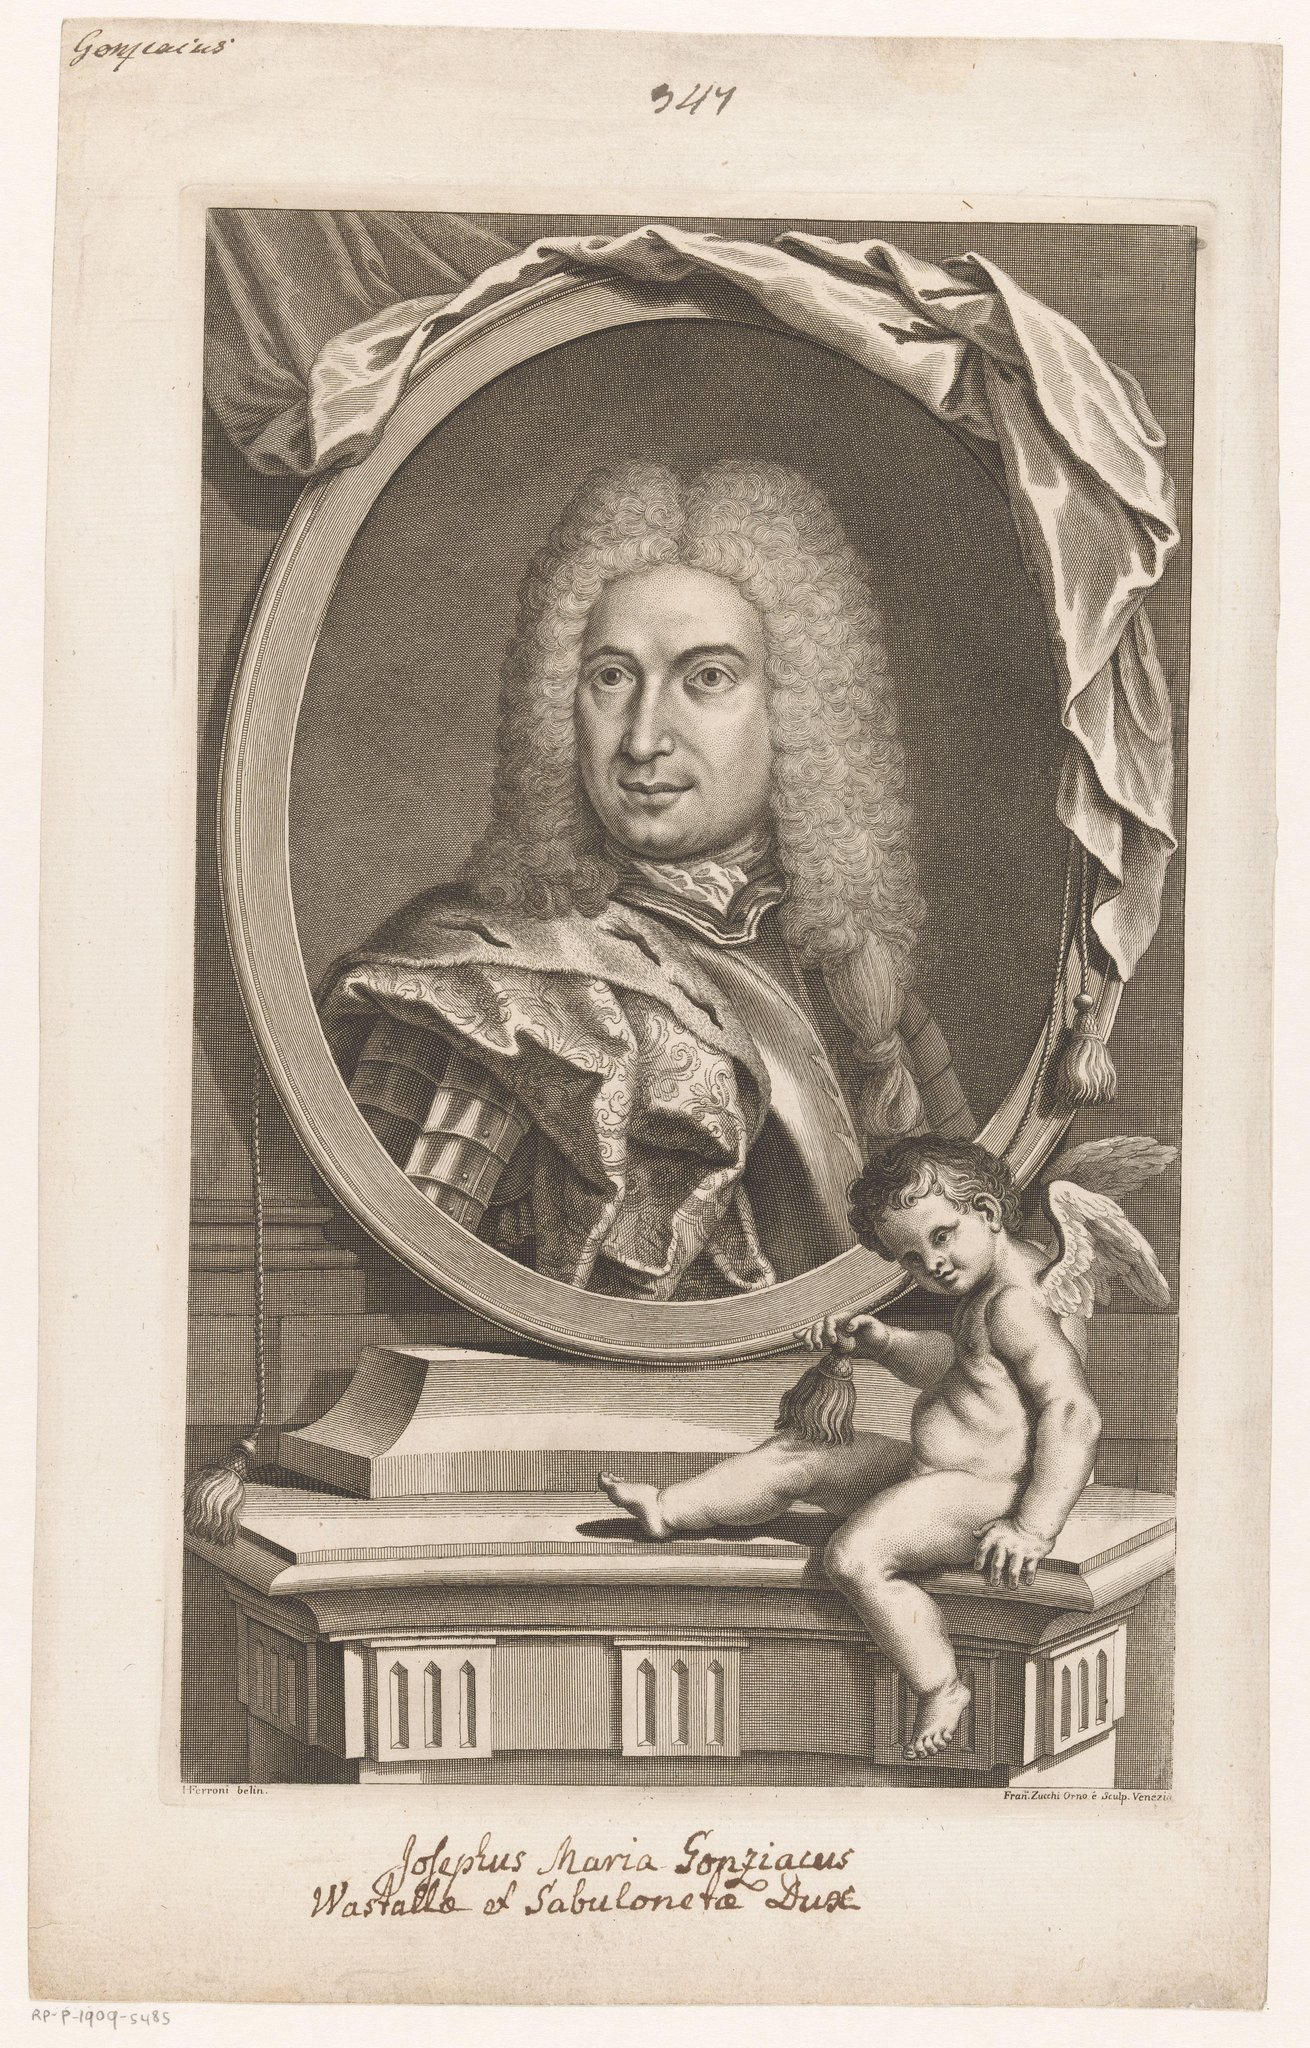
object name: print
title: Portret van Giovanni Maria Conzaga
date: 1702-1764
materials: paper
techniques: engraving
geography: italy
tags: historical persons, cupids: 'amores', 'amoretti', 'putti'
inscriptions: collector's mark: Lugt 2228, inscription: ‘Gregorius 344’, inscription: ‘Josephus Maria Gonziacus Wastalla ex Sabuloneta Dux’